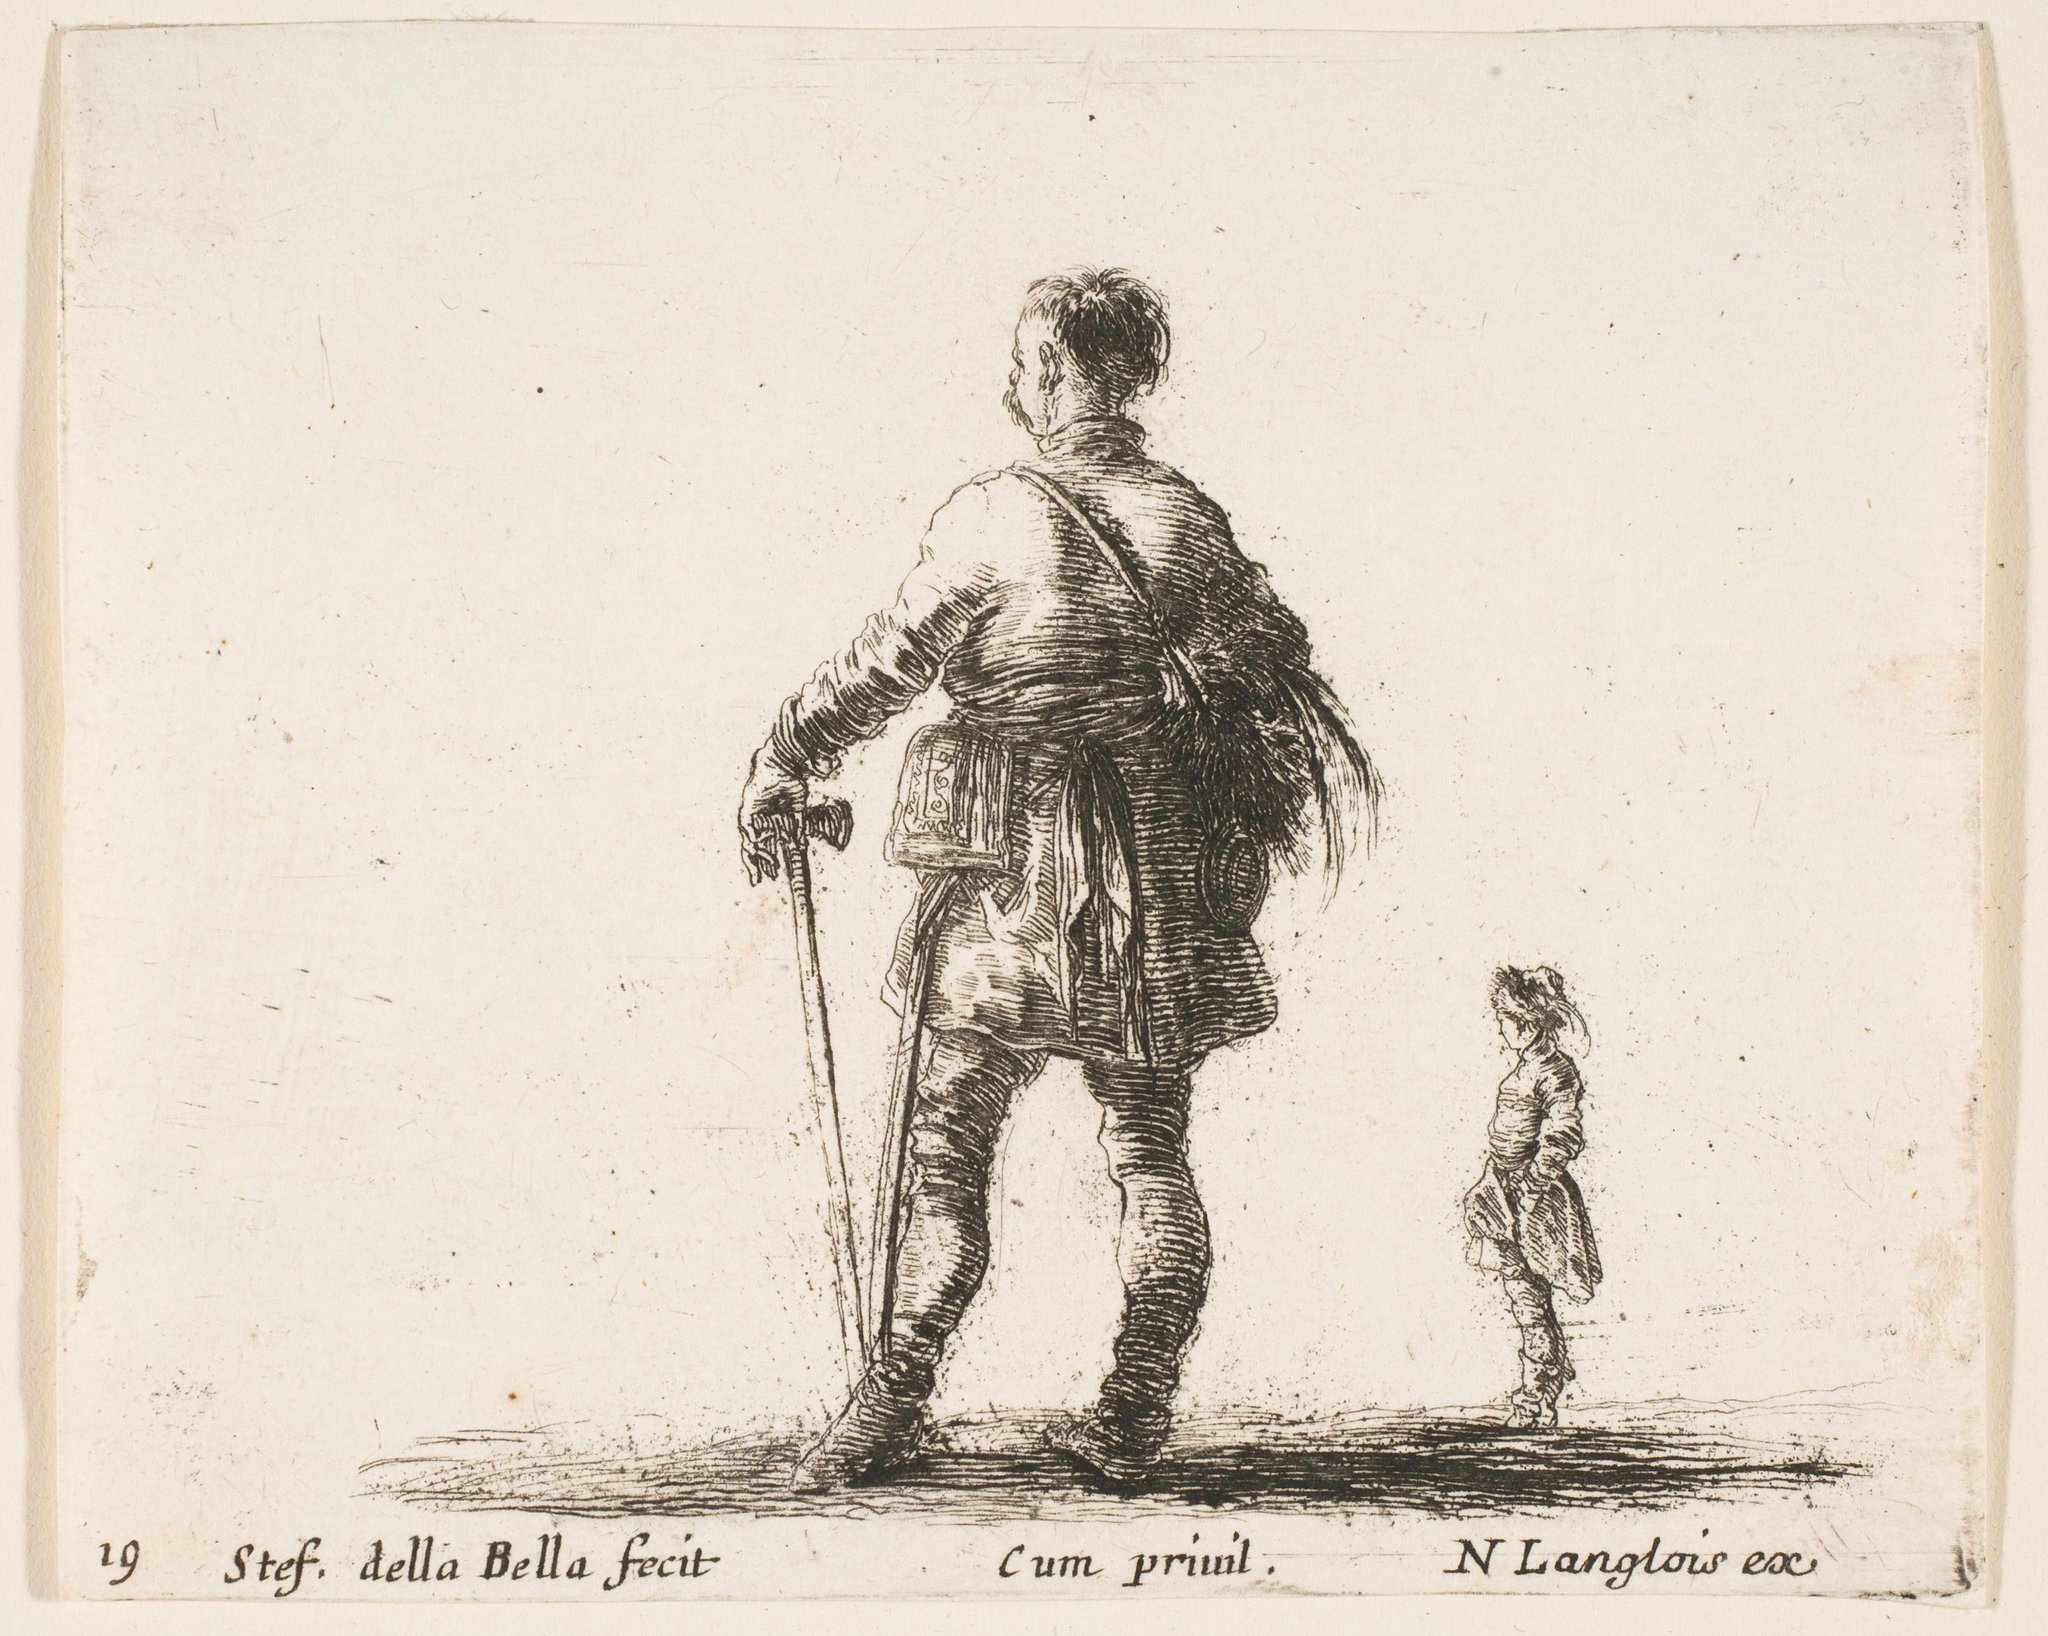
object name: print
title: A Polish nobleman in court dress, standing in center, seen from behind, another nobleman to right in background, plate 19 from "Diversi capricci"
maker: stefano della bella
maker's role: artist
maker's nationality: italian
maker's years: 1610-1664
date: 1644-1647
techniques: etching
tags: girls,men